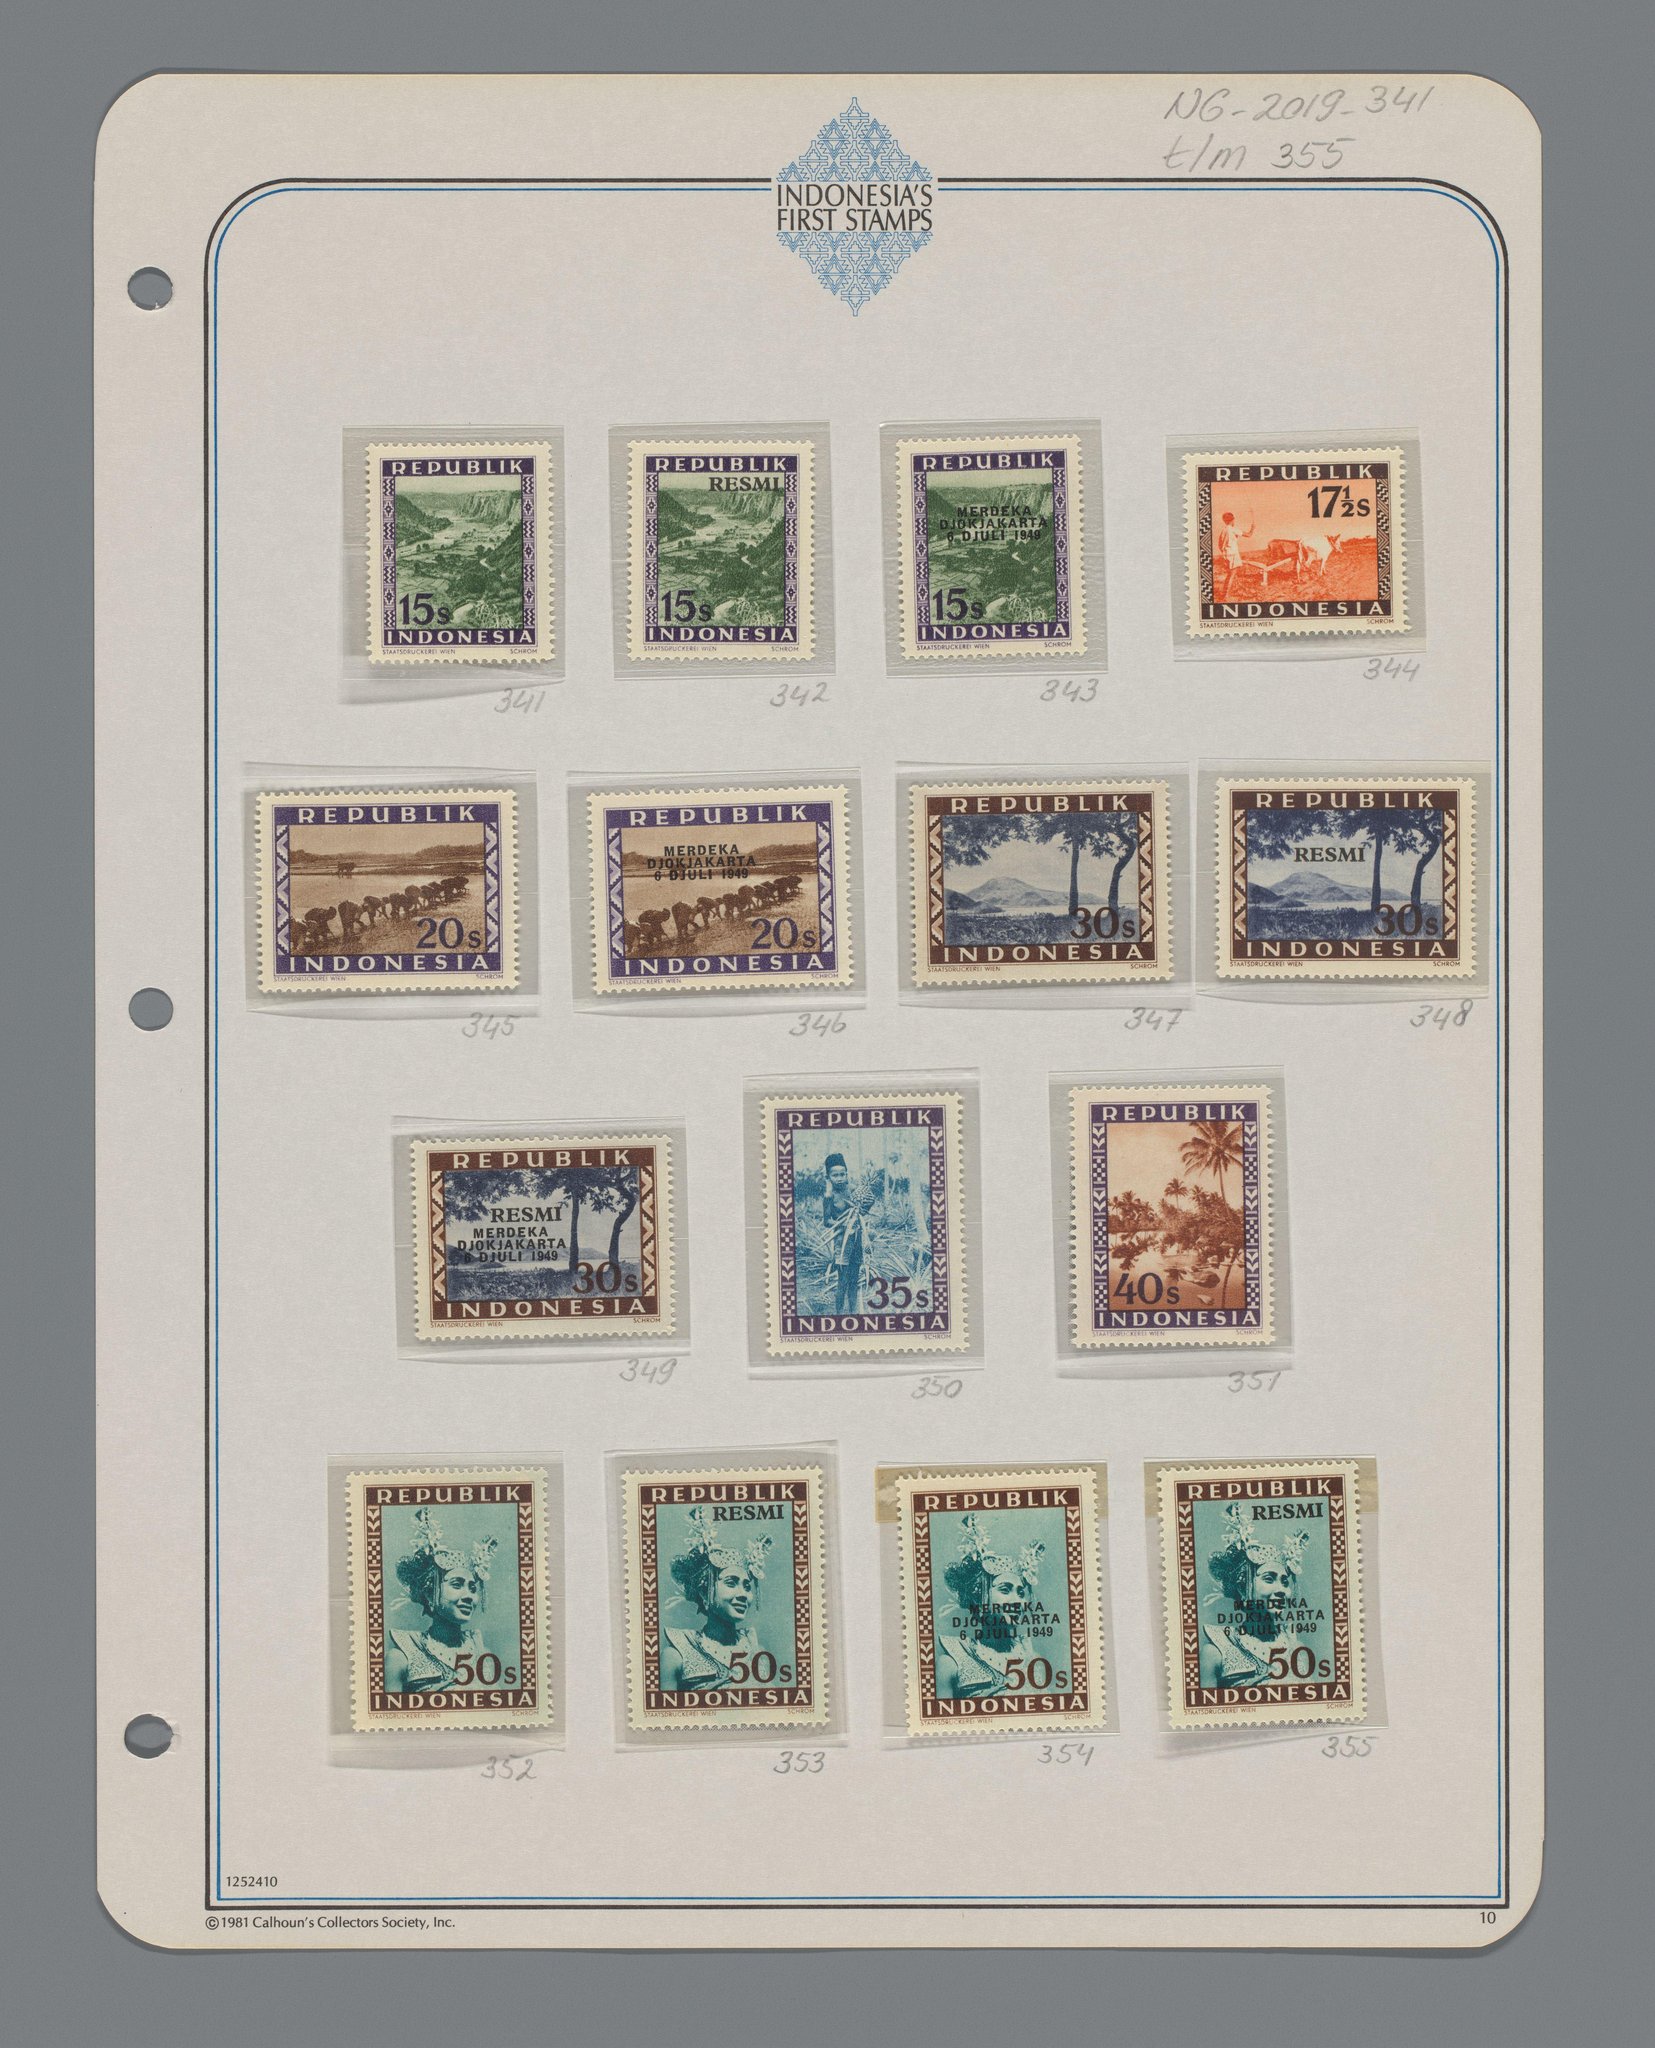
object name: postage stamp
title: Postzegel Republik Indonesia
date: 1949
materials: paper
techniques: photoaquatint, engraving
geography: vienna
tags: indonesia